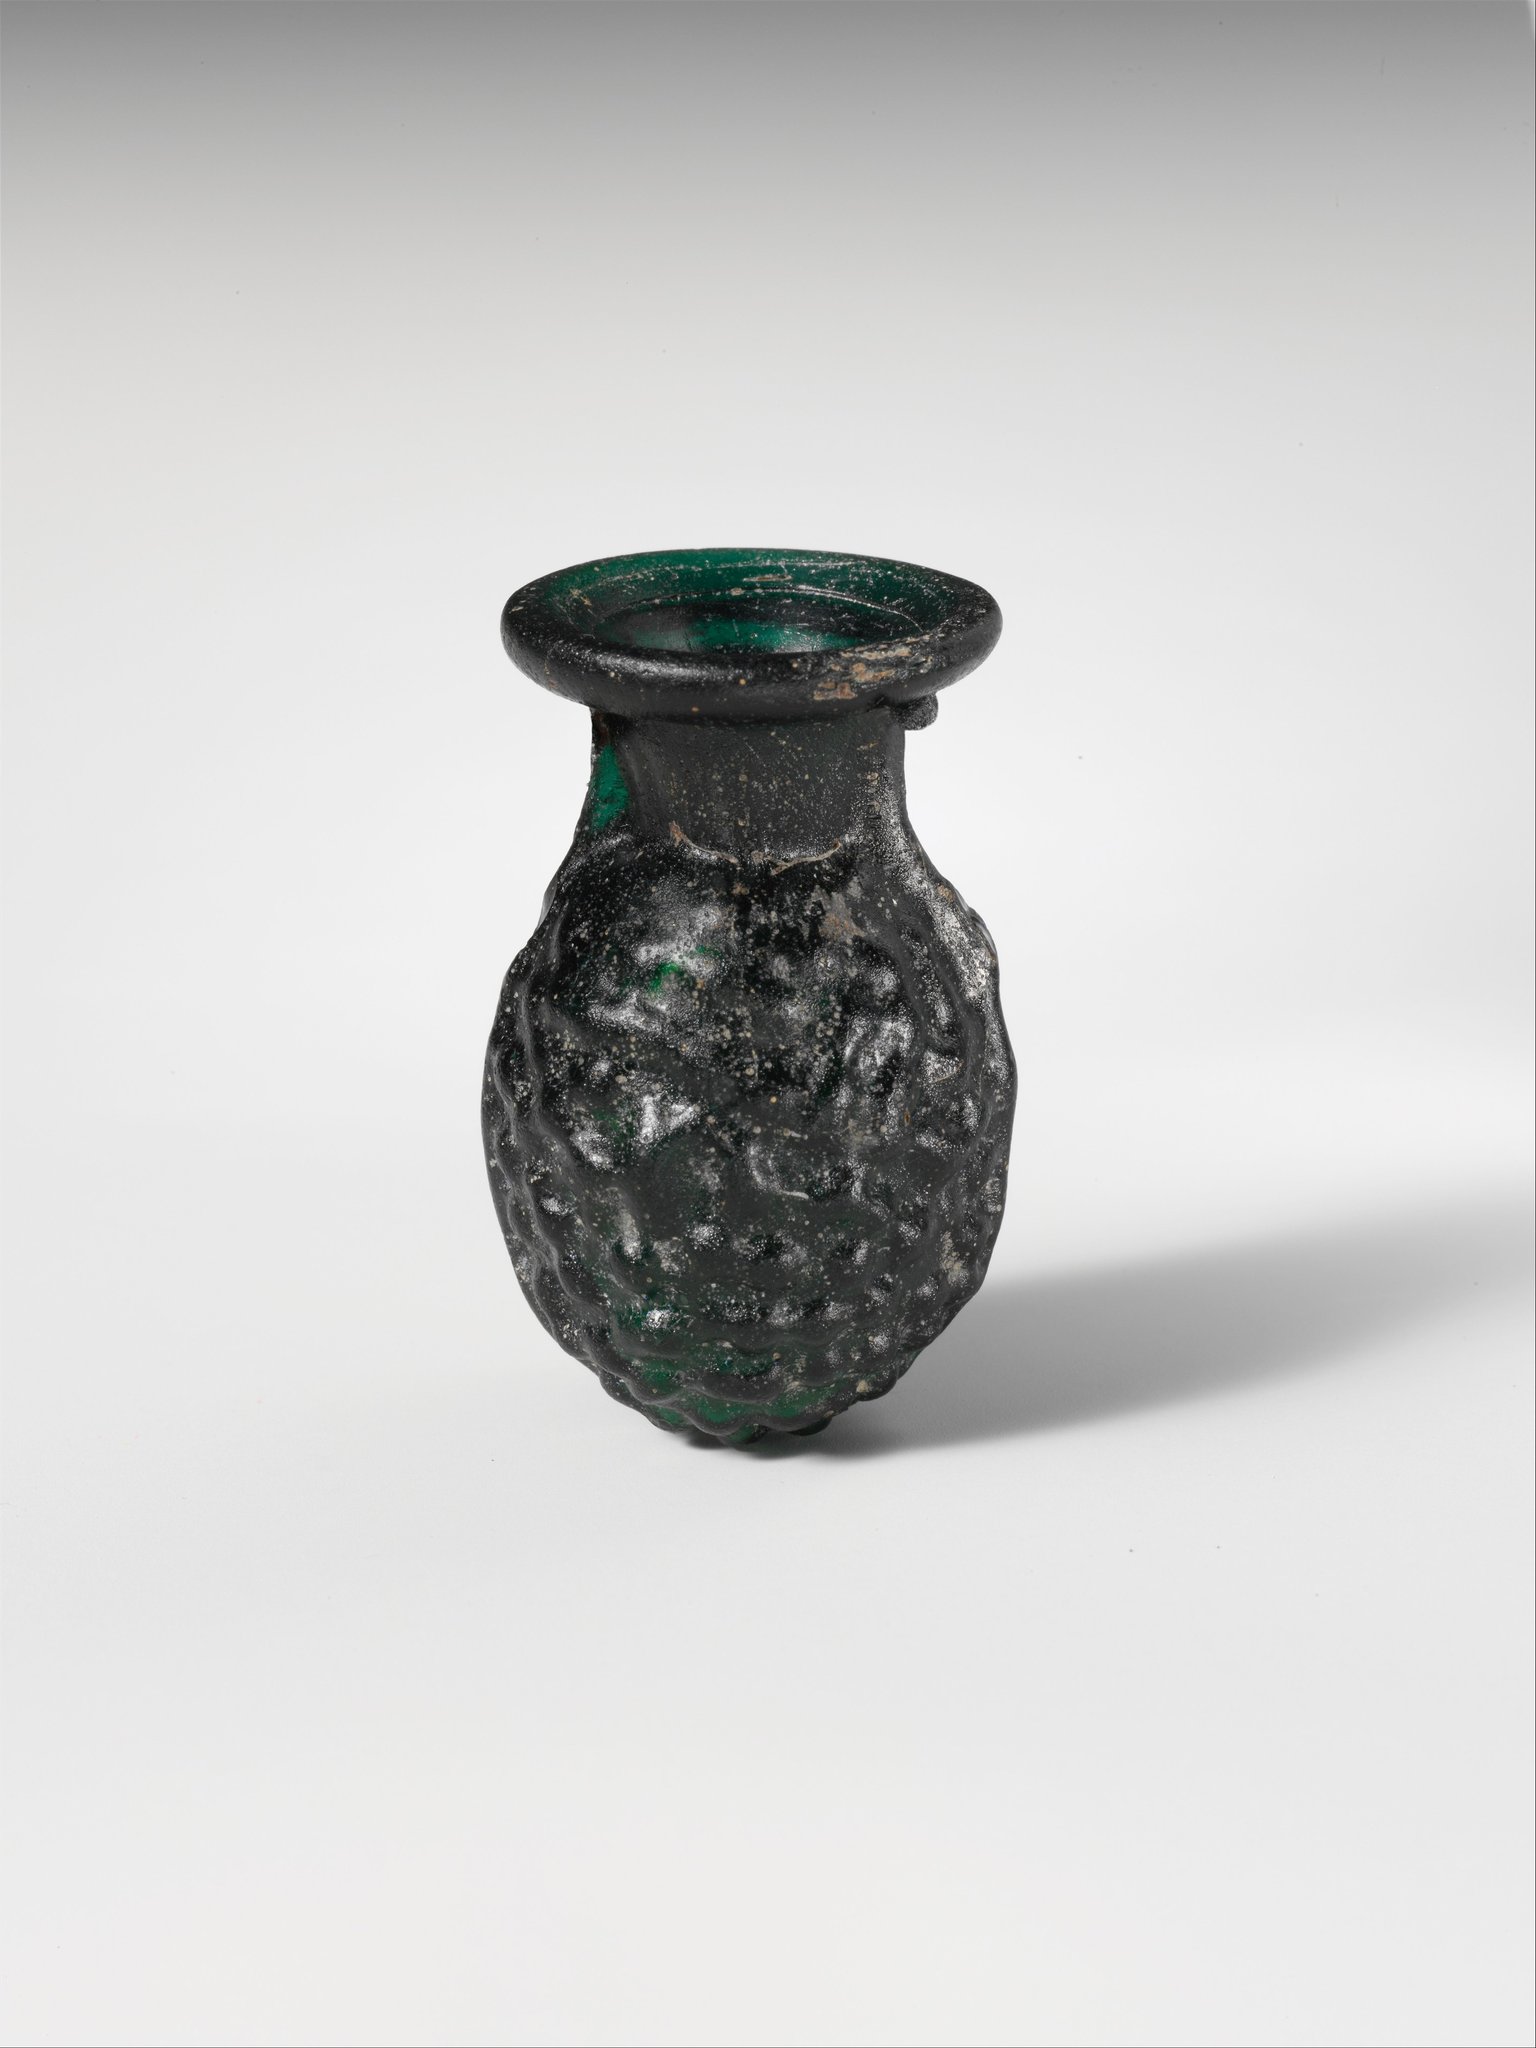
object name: flask with stylized grape cluster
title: Glass grape flask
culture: roman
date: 67-200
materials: glass